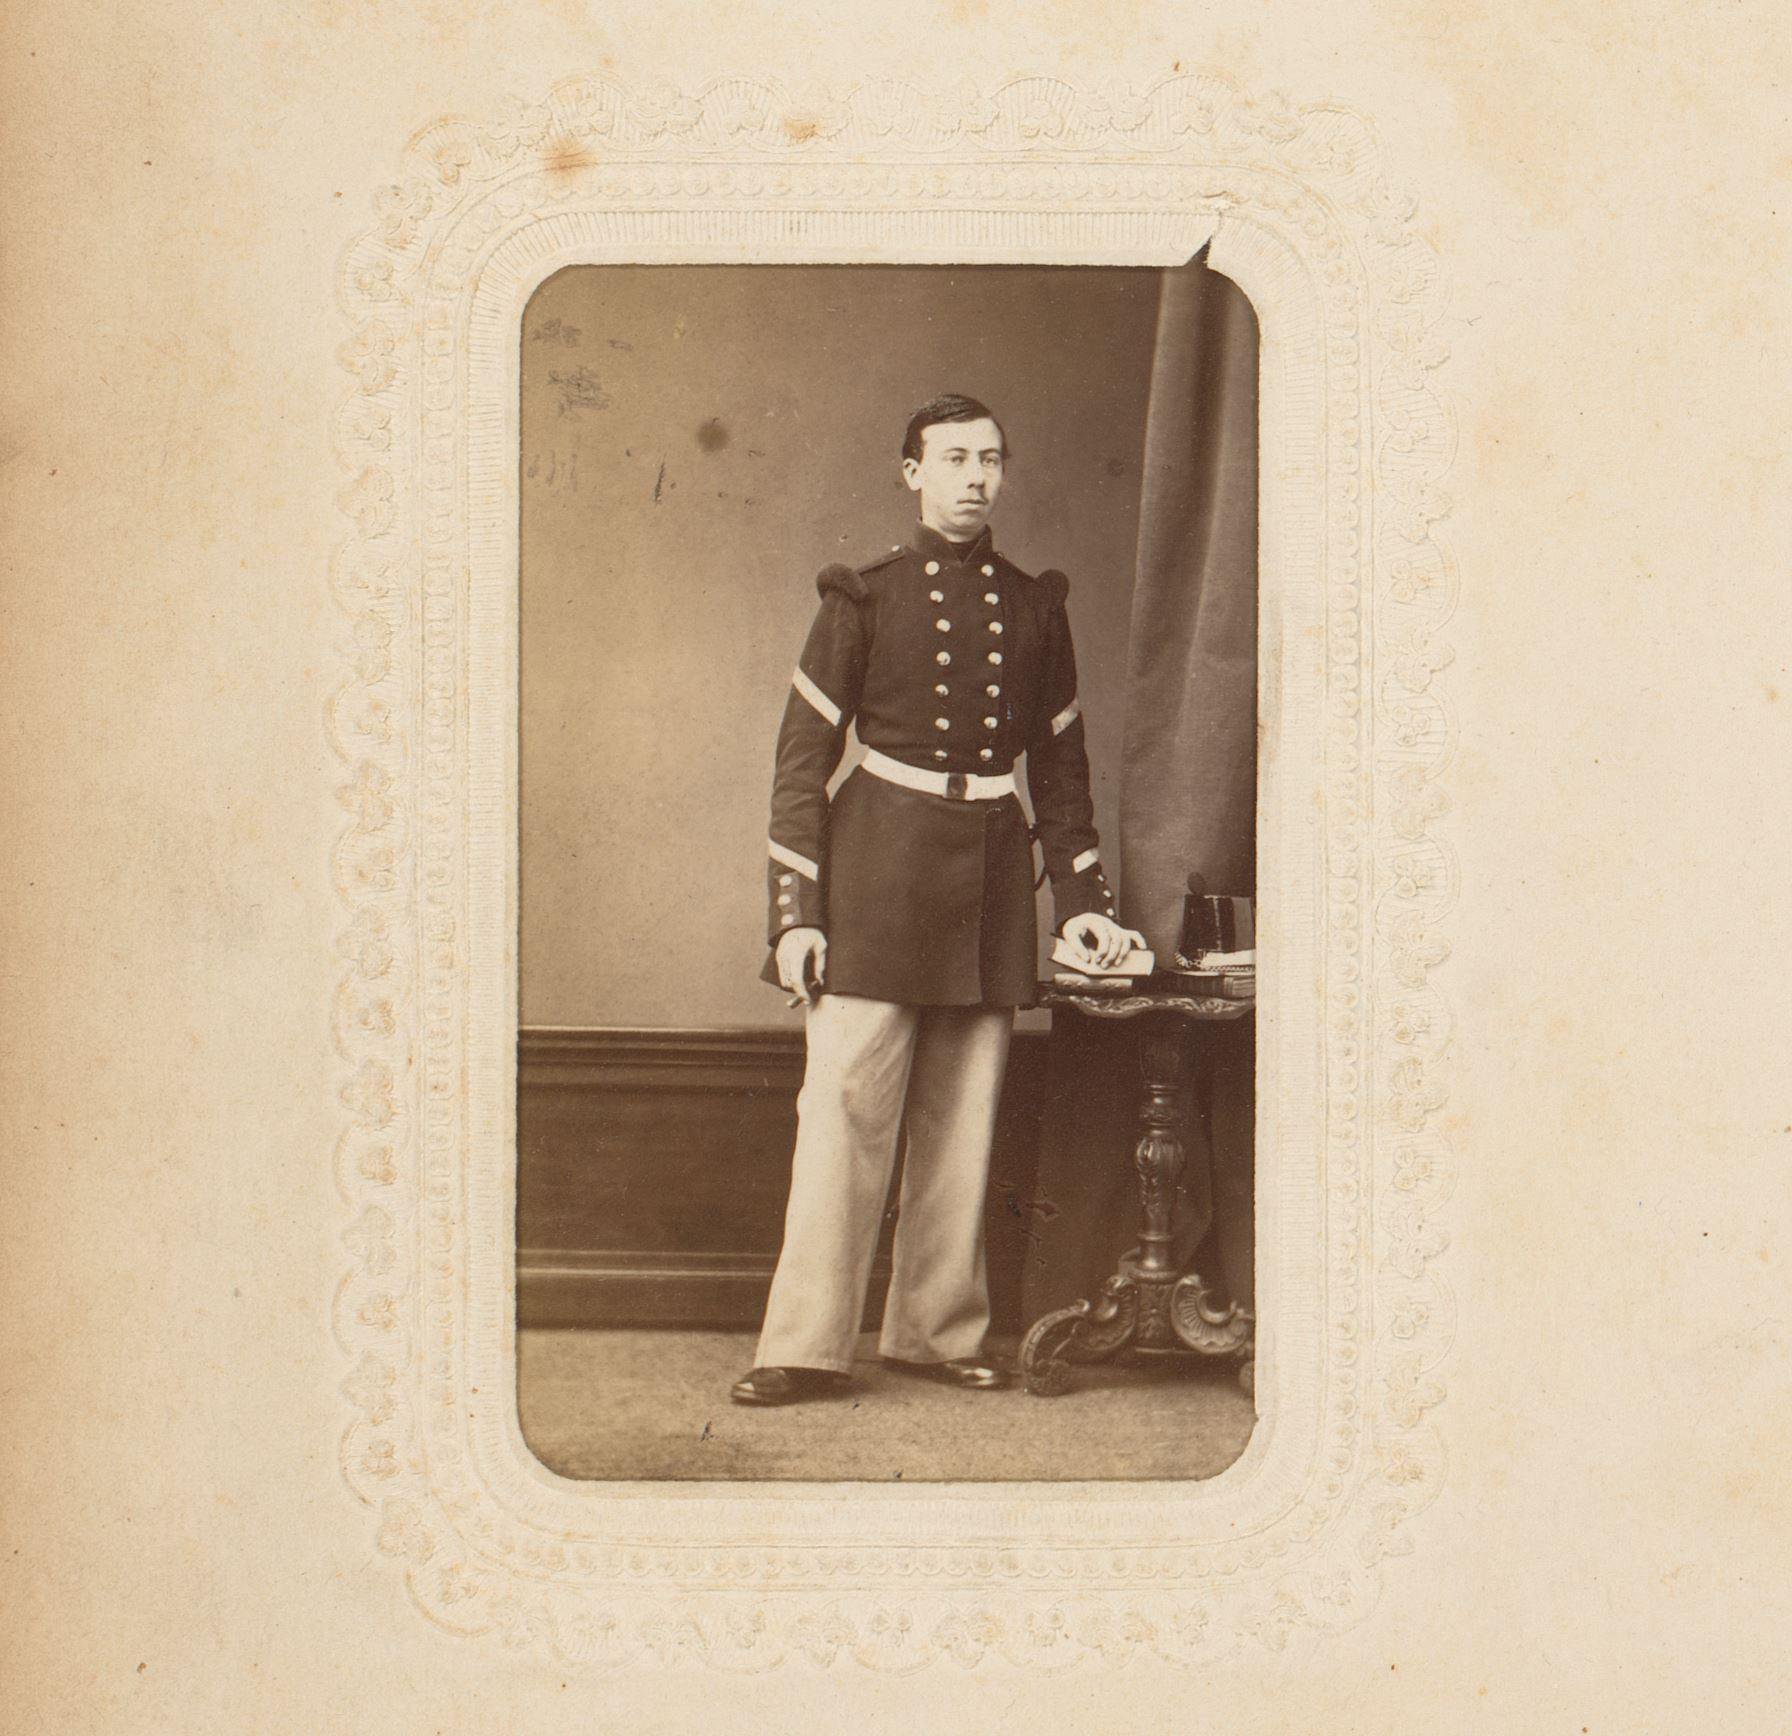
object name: photograph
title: Portret van een jongeman in uniform met sigaar en boek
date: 1865-1874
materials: cardboard, photographic support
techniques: albumen print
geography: brussels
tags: cigar, historical persons, (military) uniforms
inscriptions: inscription: ‘Trumper Frères/ photographes/ Rue Névraumont, No 1/ station du Nord/ Bruxelles/ Atelier de Pose au Rez-de-Chaussée’